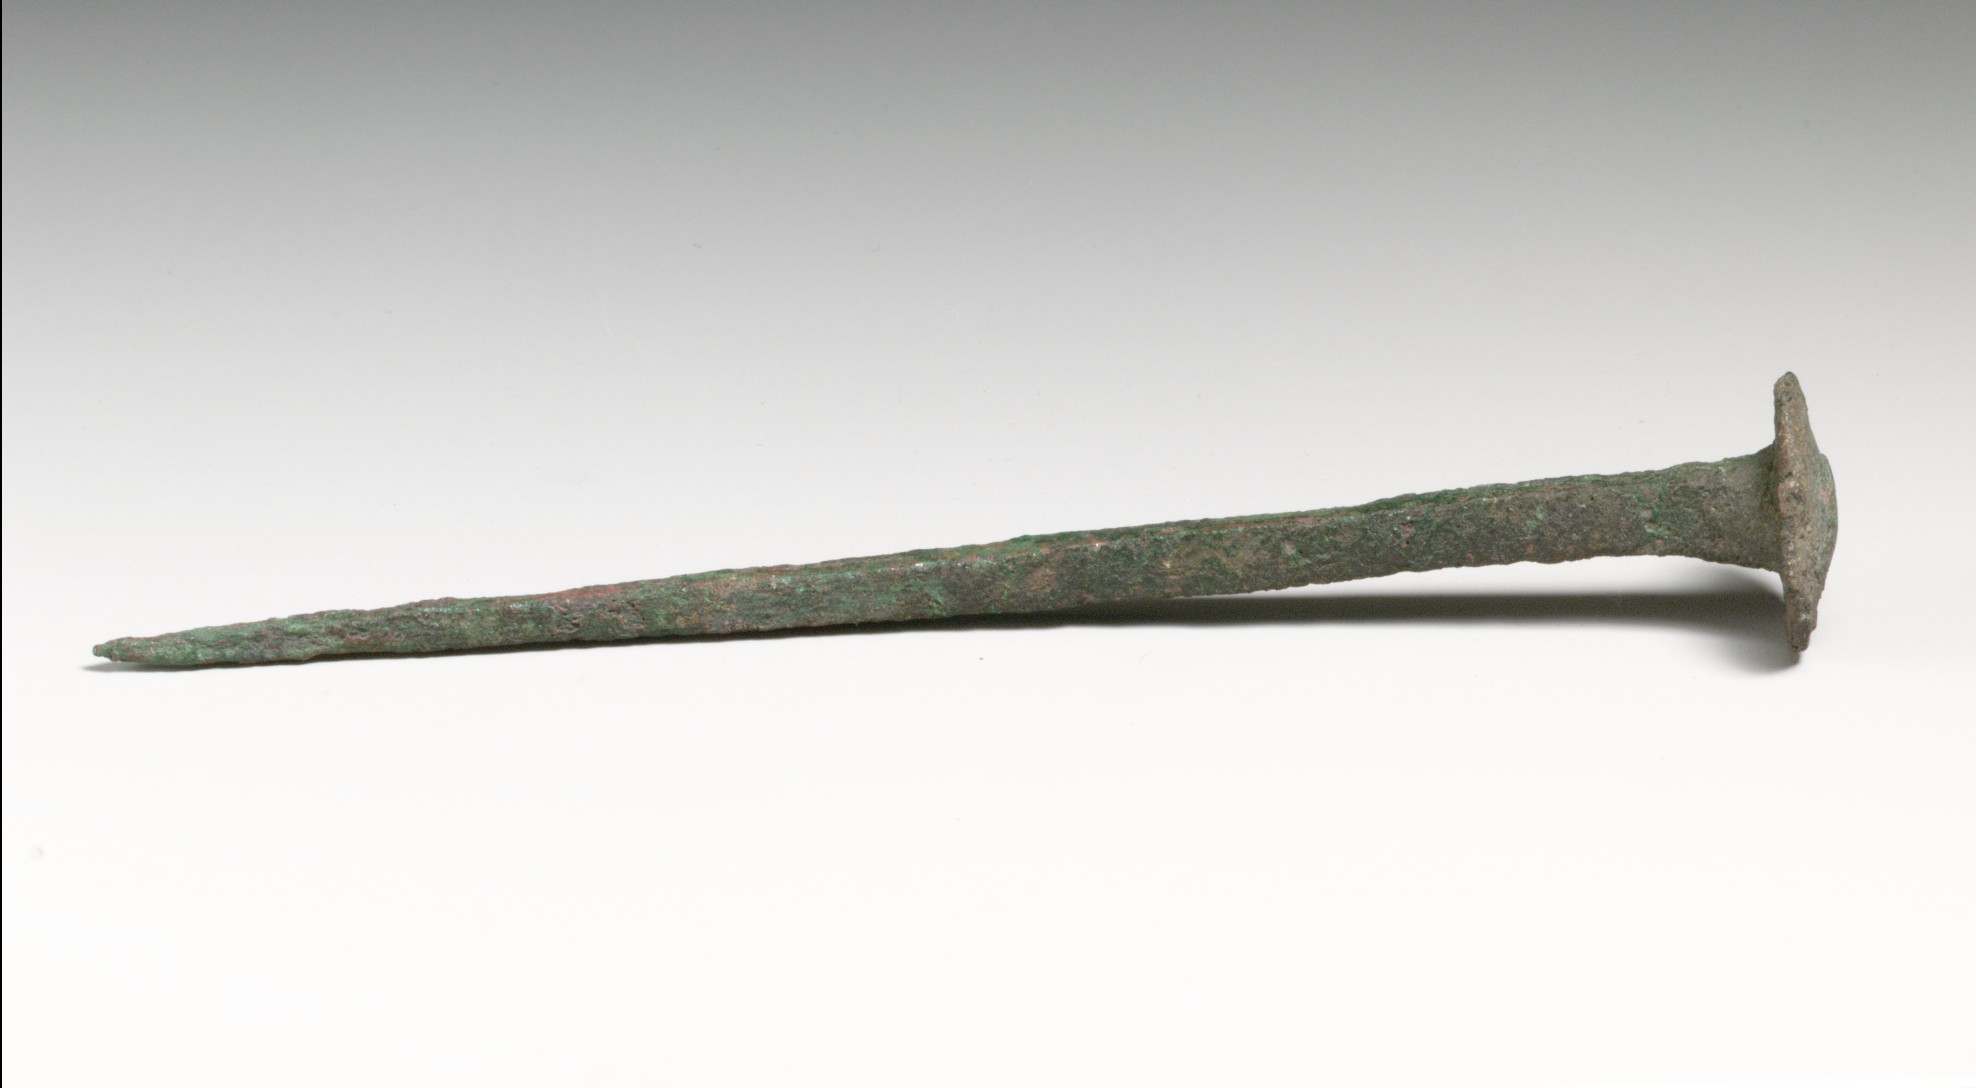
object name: nail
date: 7000 BCE-330 CE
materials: bronze